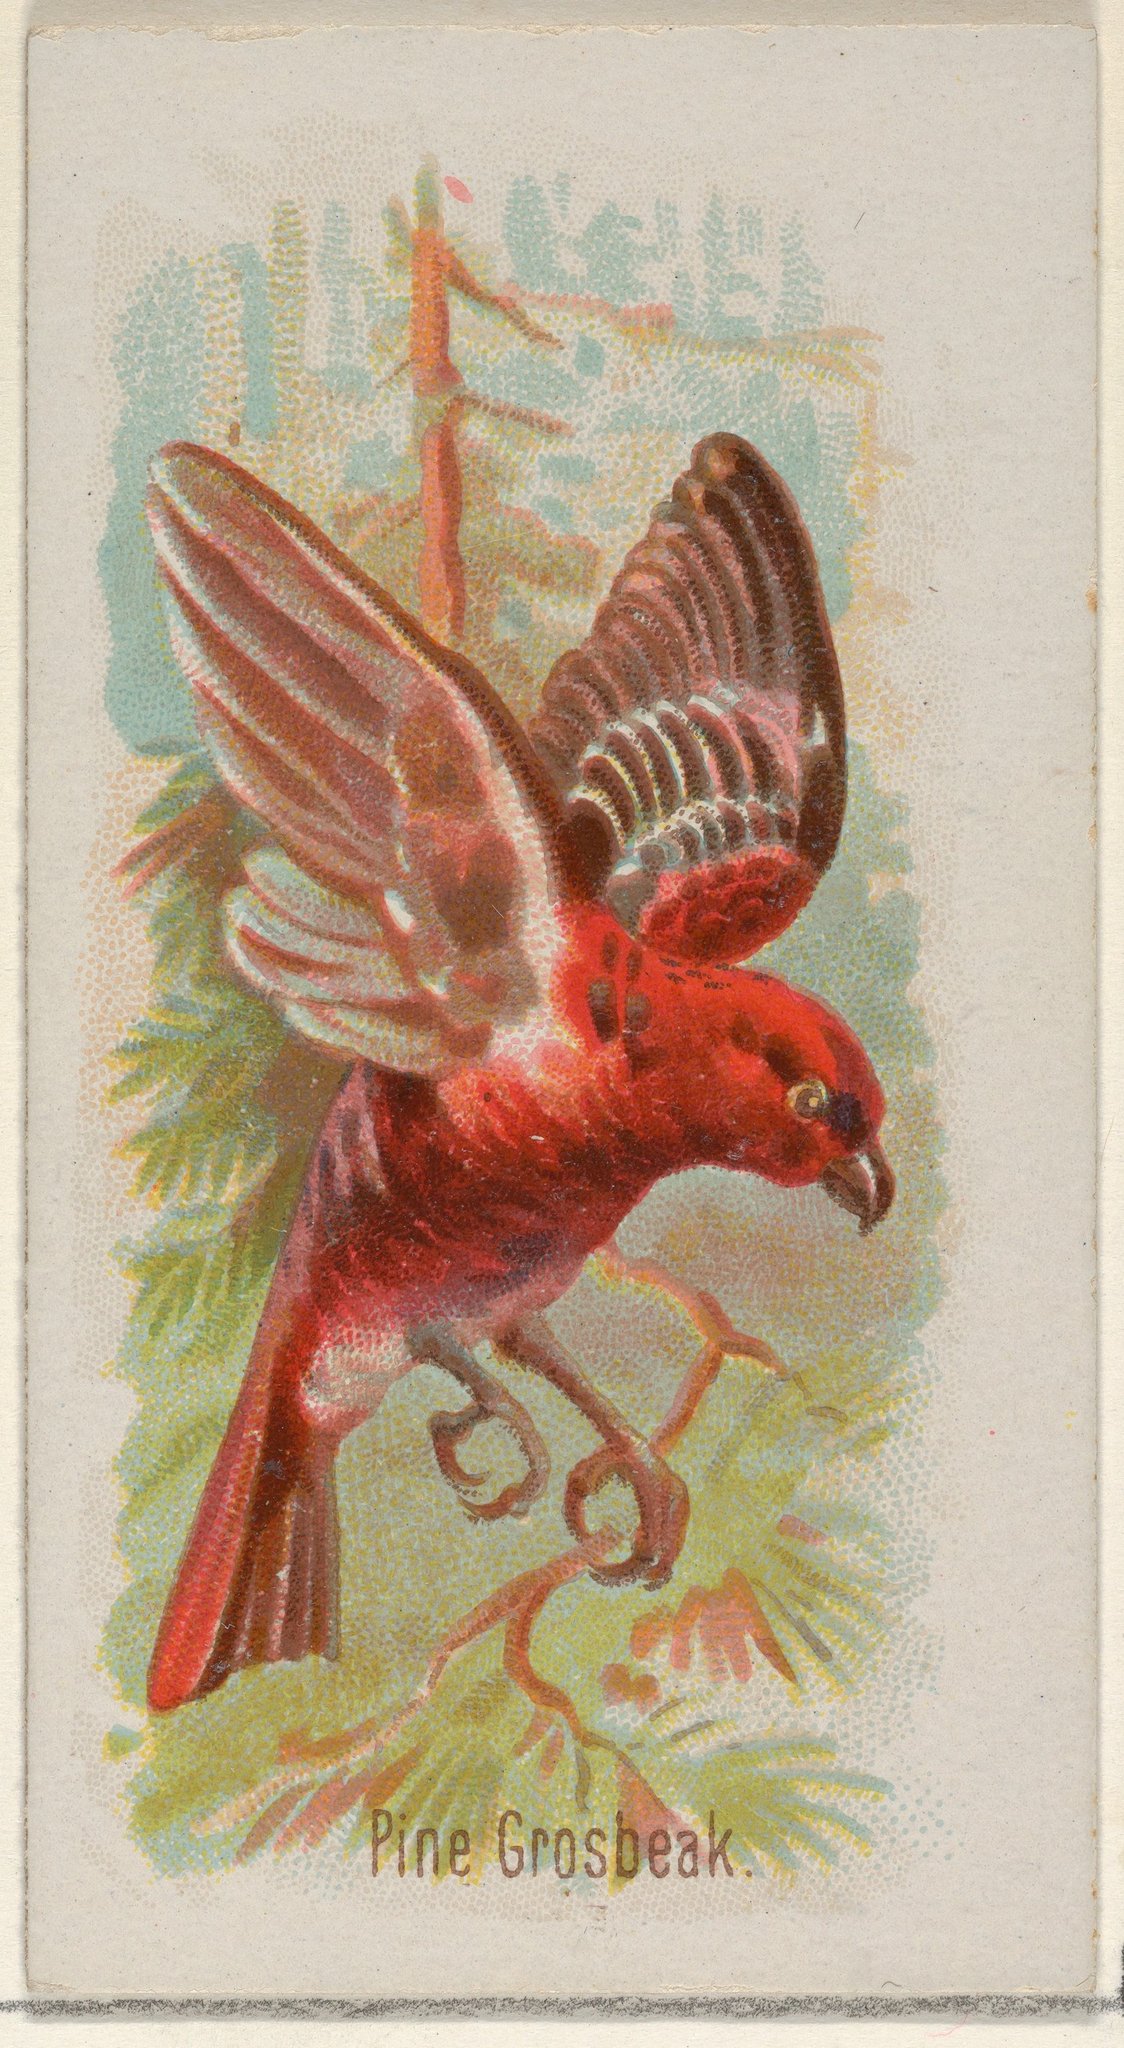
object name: print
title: Pine Grosbeak, from the Song Birds of the World series (N23) for Allen & Ginter Cigarettes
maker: allen & ginter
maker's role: publisher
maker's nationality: american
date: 1890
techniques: color lithograph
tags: birds